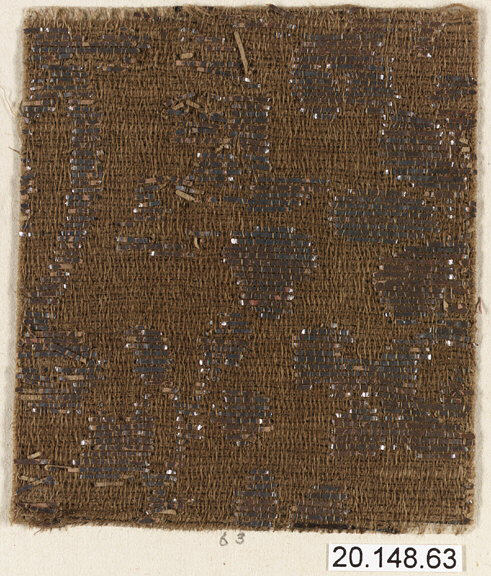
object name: piece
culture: japanese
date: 1401-1500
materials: silk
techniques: compound weave